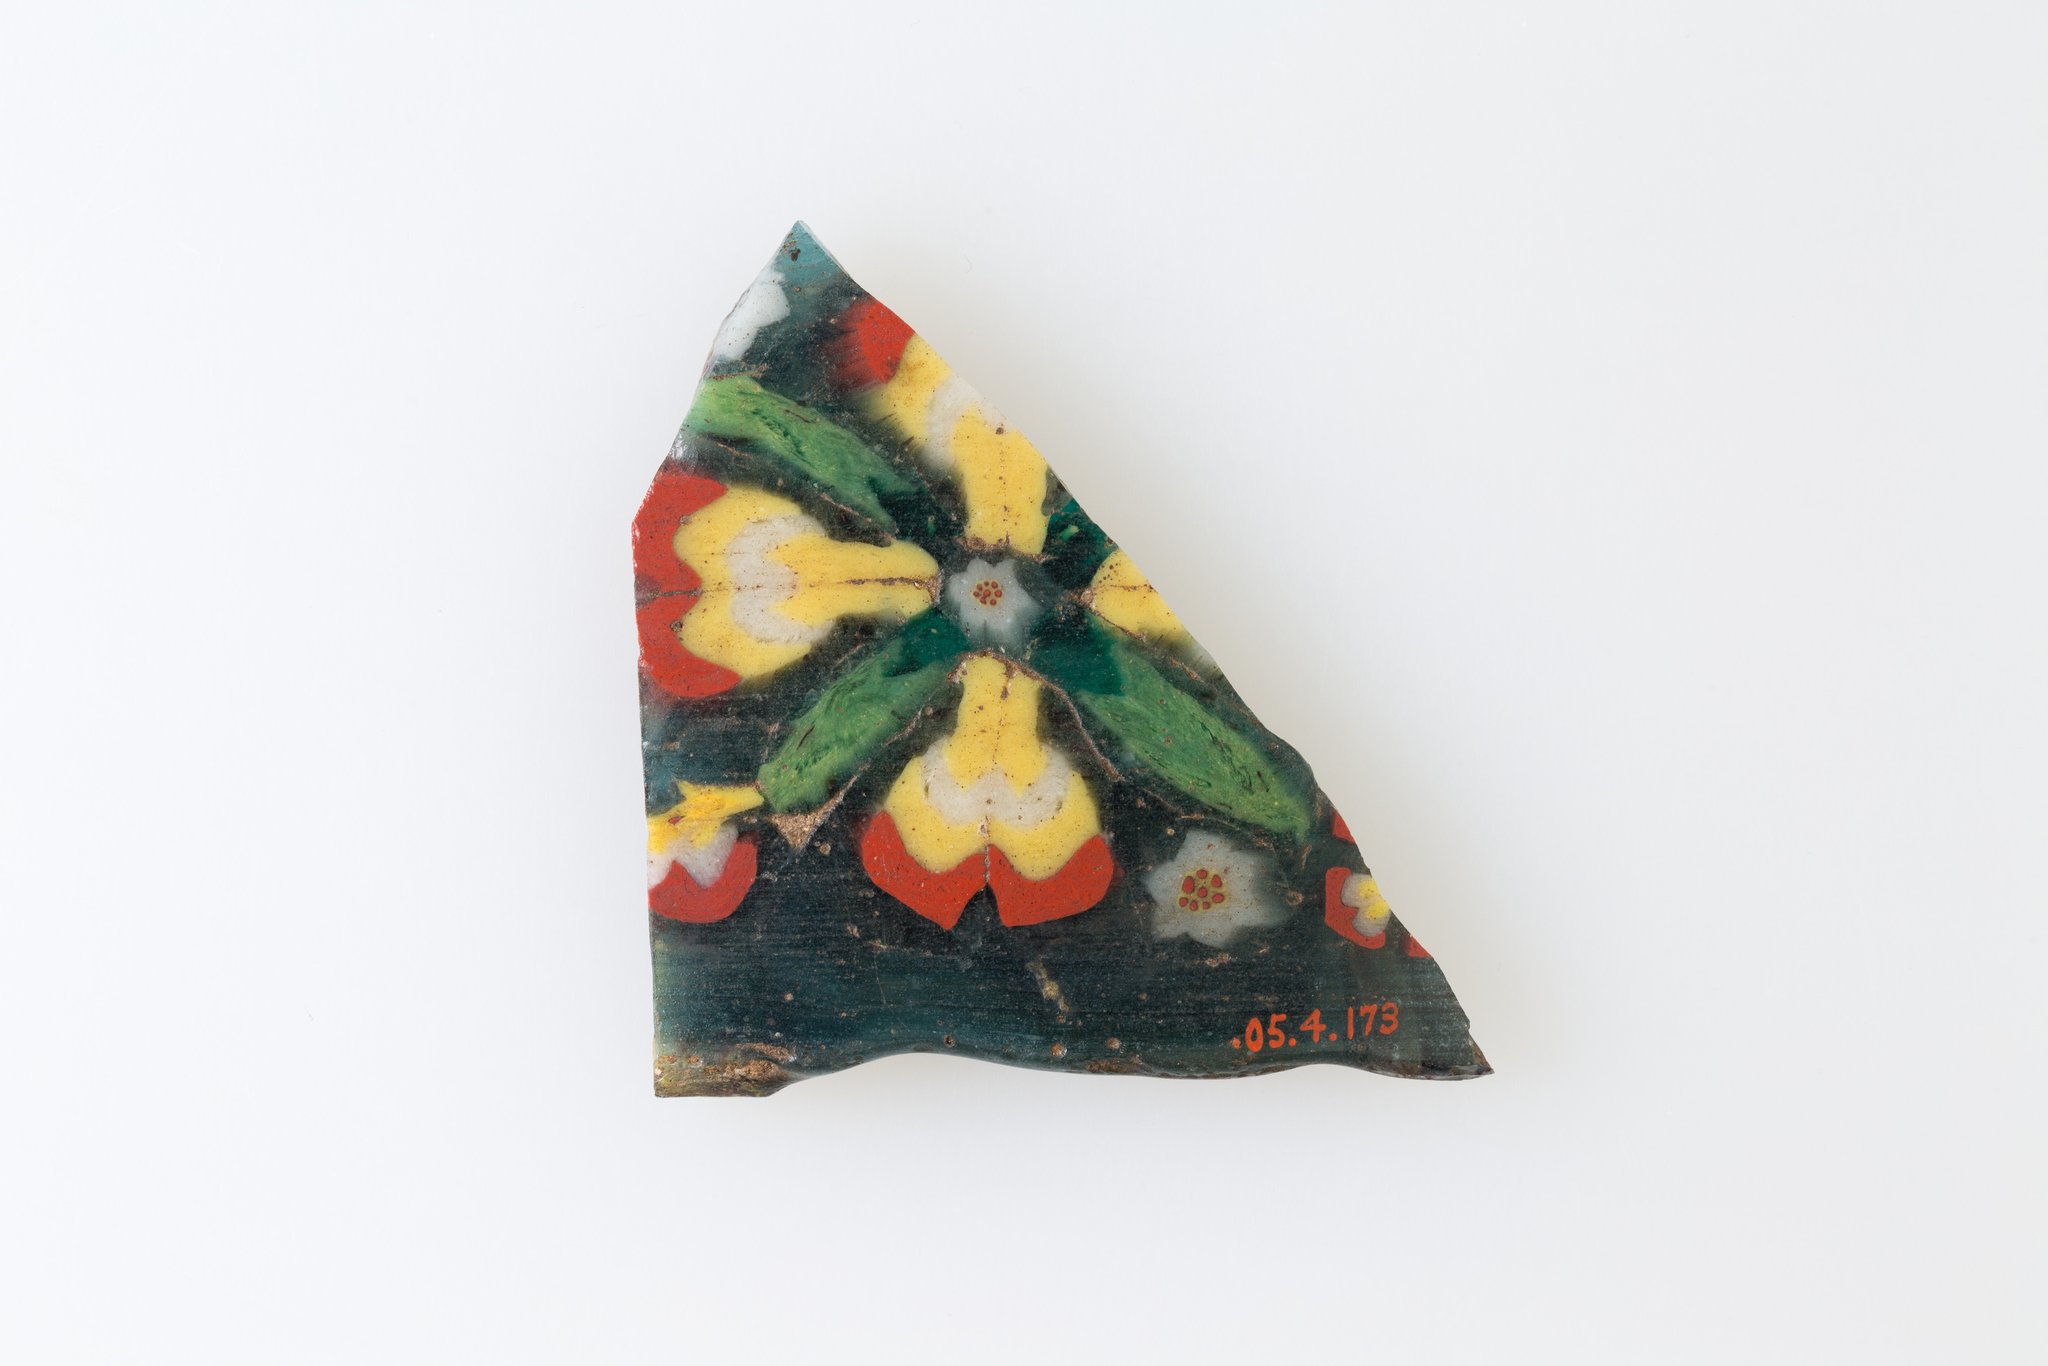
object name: floral plaque, fragment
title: Fragment of floral plaque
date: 100 BCE-100 CE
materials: glass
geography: egypt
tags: flowers